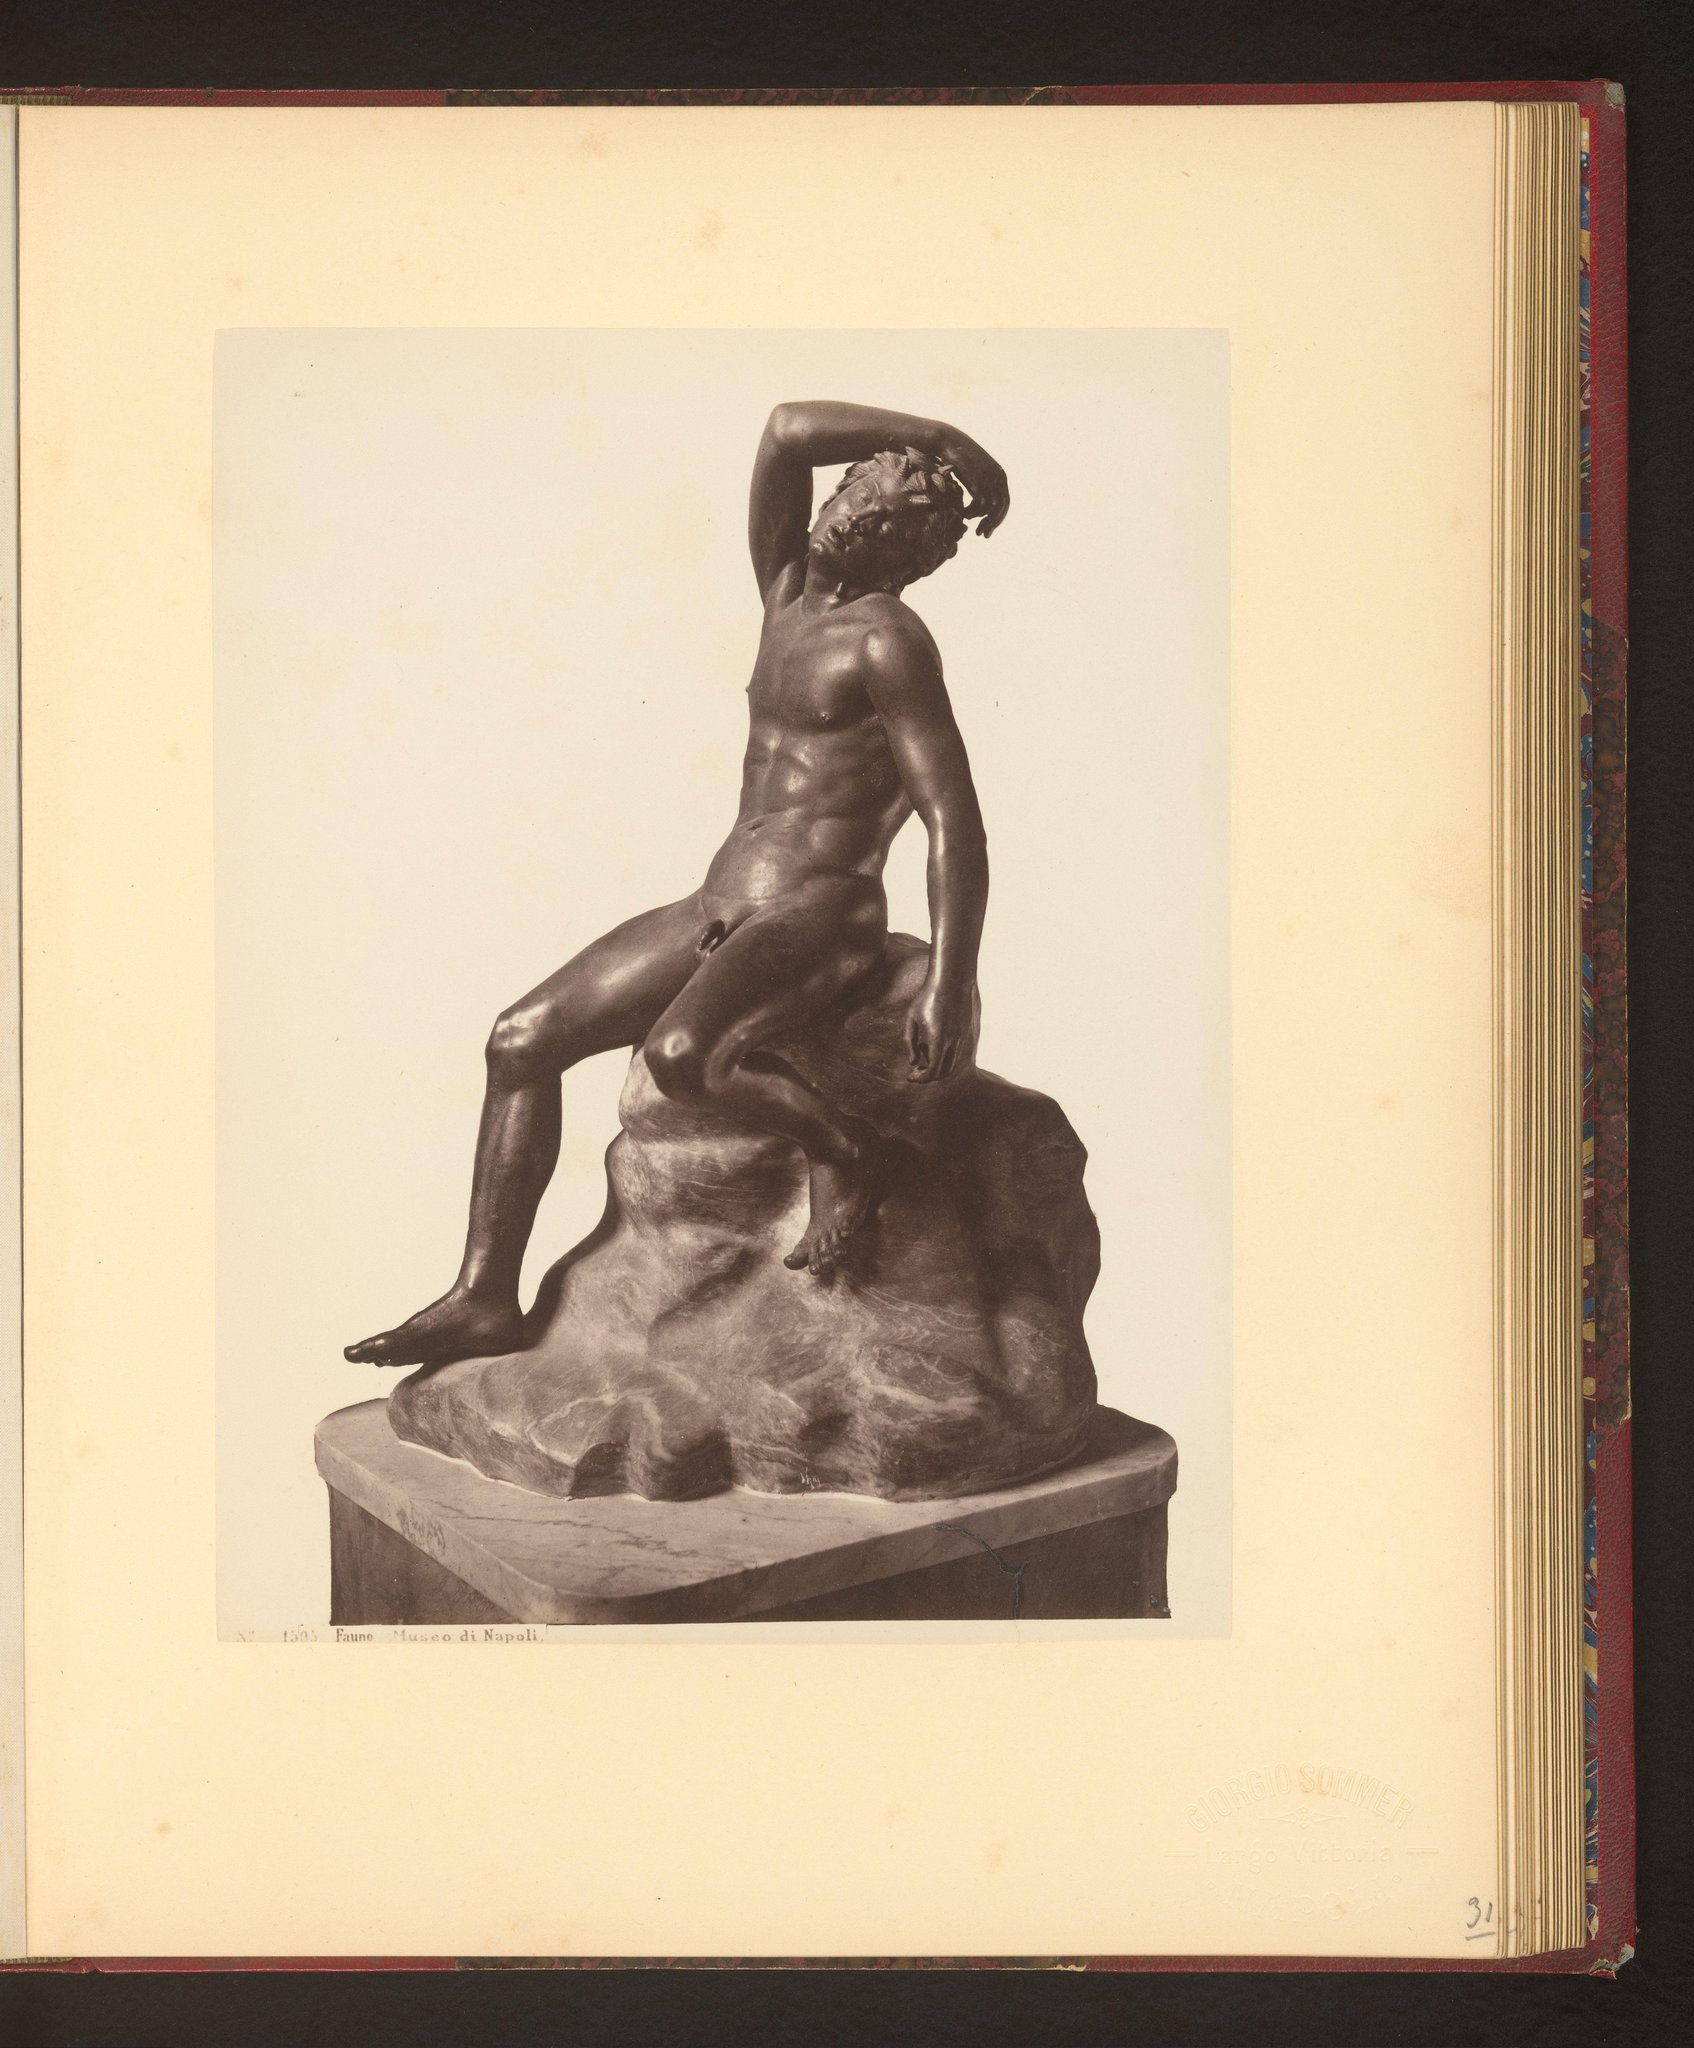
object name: album leaf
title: Bronzen sculptuur van een slapende sater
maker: giorgio sommer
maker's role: fotograaf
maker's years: 1834-1914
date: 1874-1879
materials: photographic support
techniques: albumen print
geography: naples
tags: sculpture (+ bronze ~ arts), satyr(s) (in general)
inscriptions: number: ‘1505’, workshop stamp: ‘Giorgio Sommer/ Largo Vittoria/ Napoli’